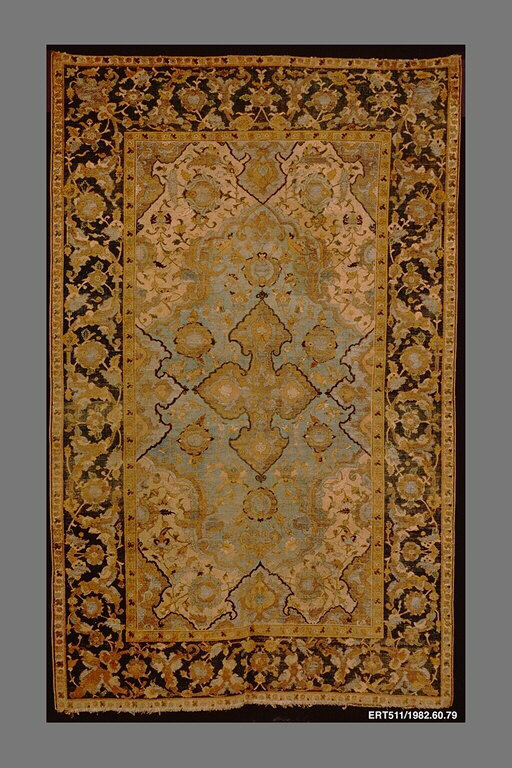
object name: rug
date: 1601-1700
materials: cotton, metal thread, silk